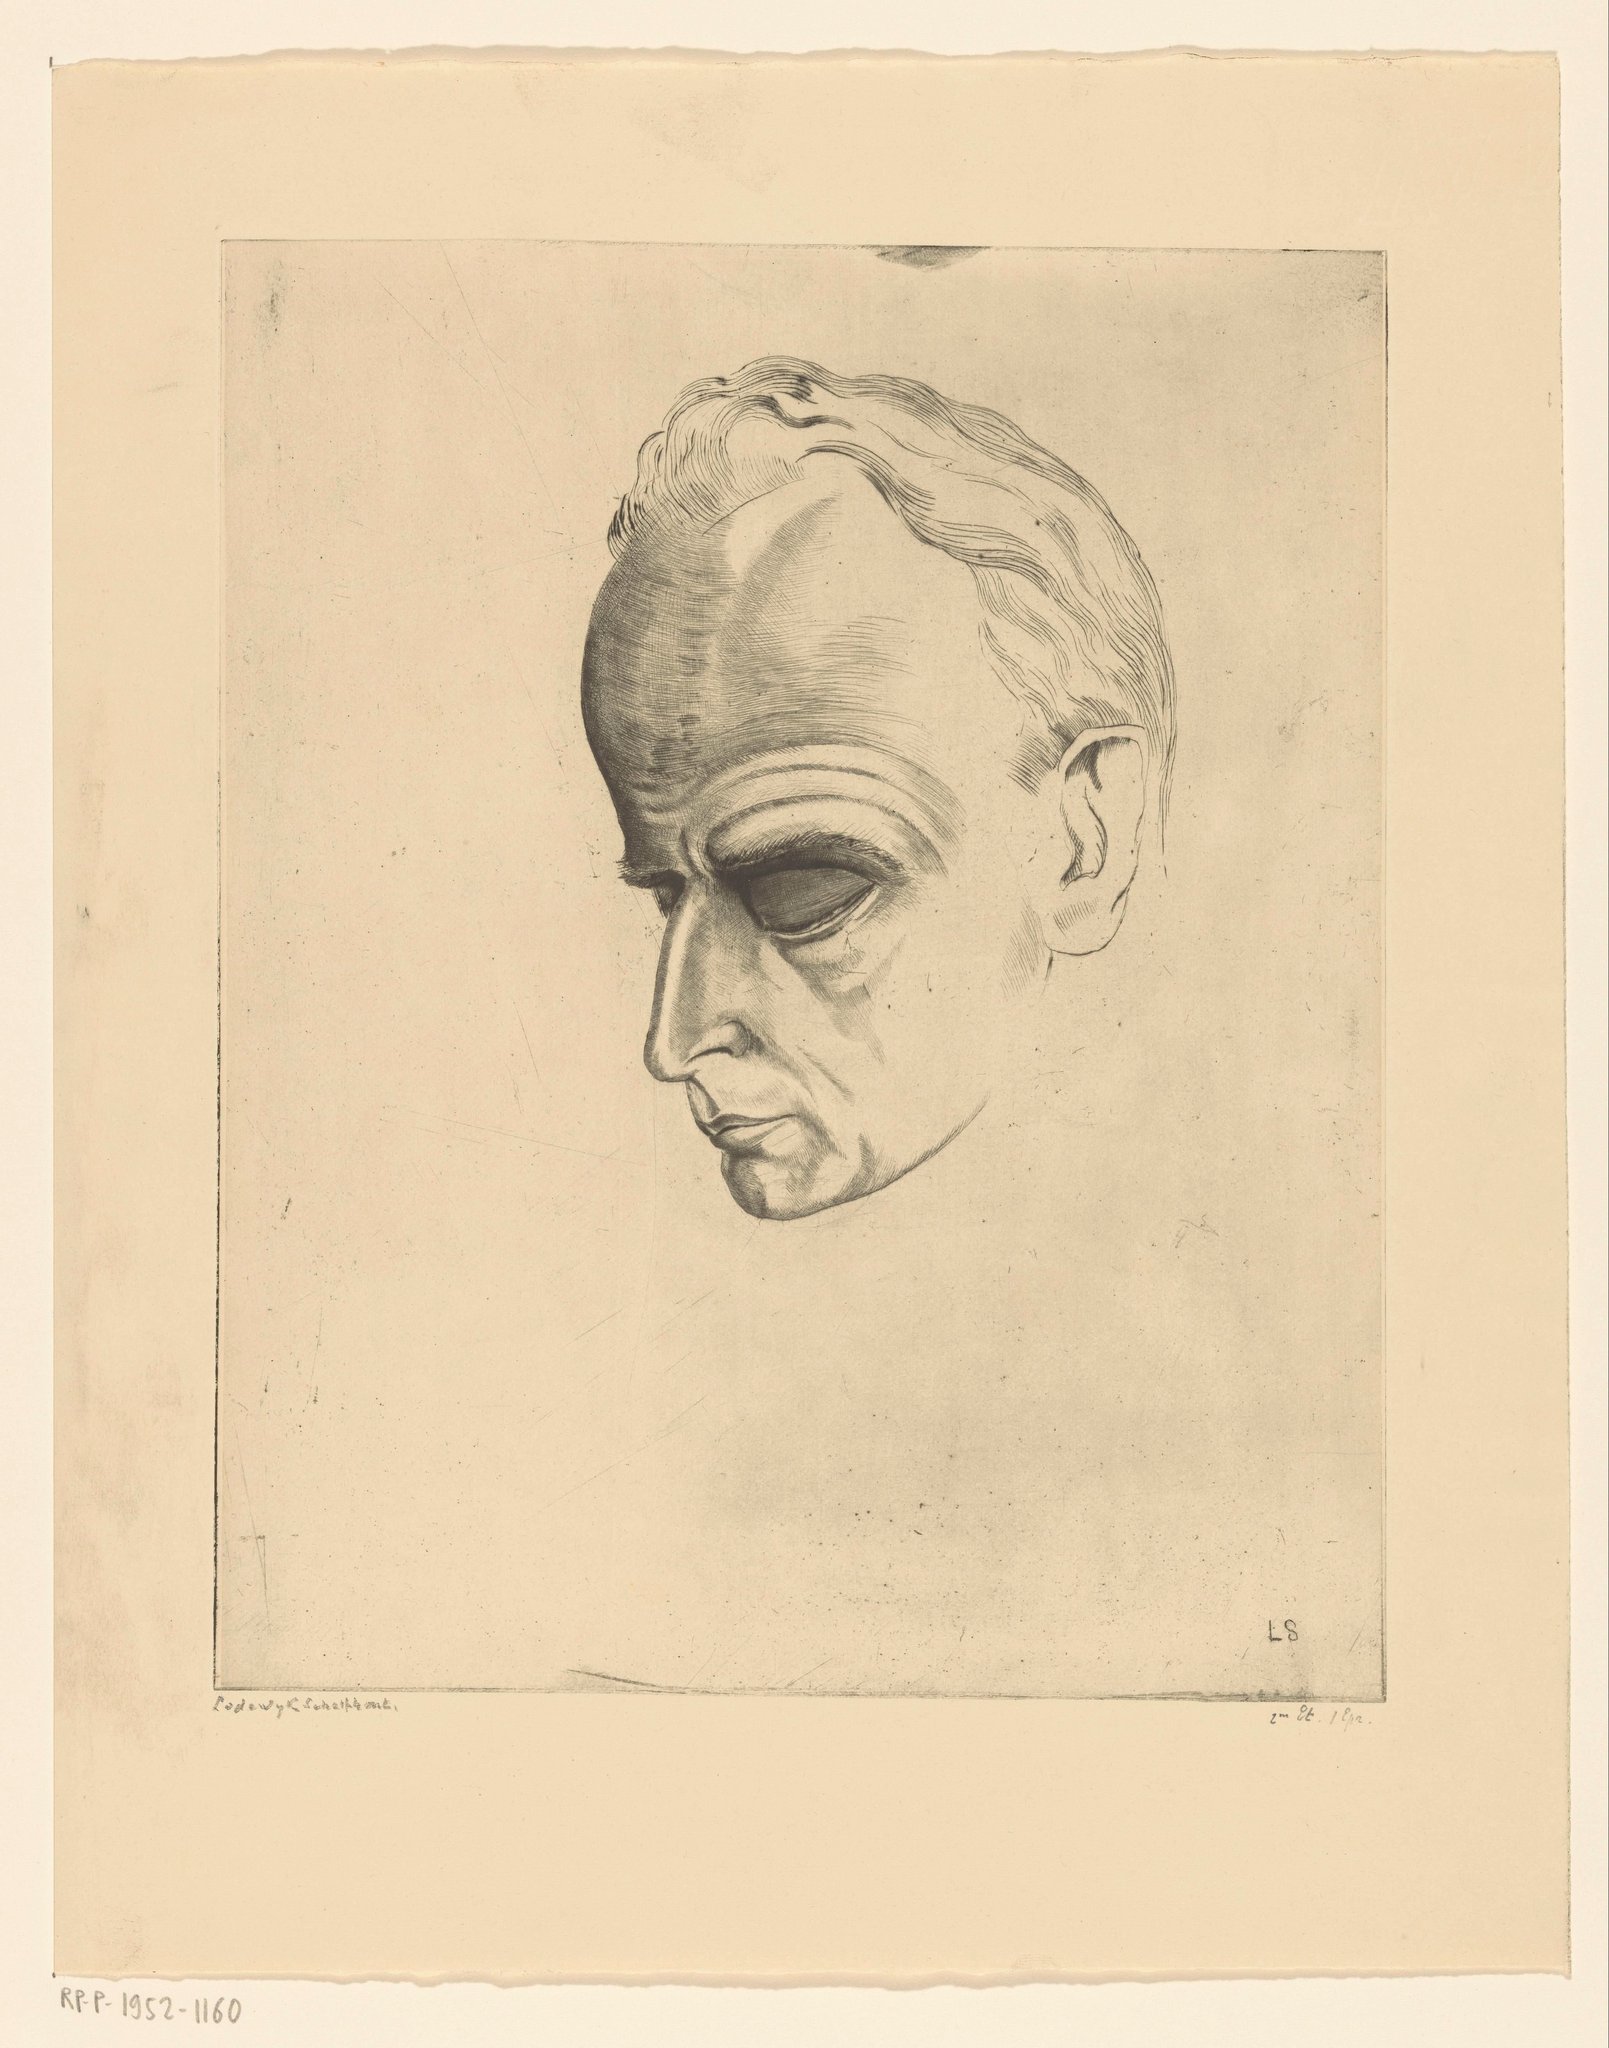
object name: print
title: Portret van Ferdinand Bordewijk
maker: lodewijk schelfhout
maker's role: draughtsman, print maker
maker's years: 1881-1943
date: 1936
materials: paper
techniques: drypoint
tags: amsterdam, the hague, writer, poet, author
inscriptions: collector's mark: Lugt 2228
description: Een portret van schrijver Ferdinand Bordewijk, met gesloten ogen.